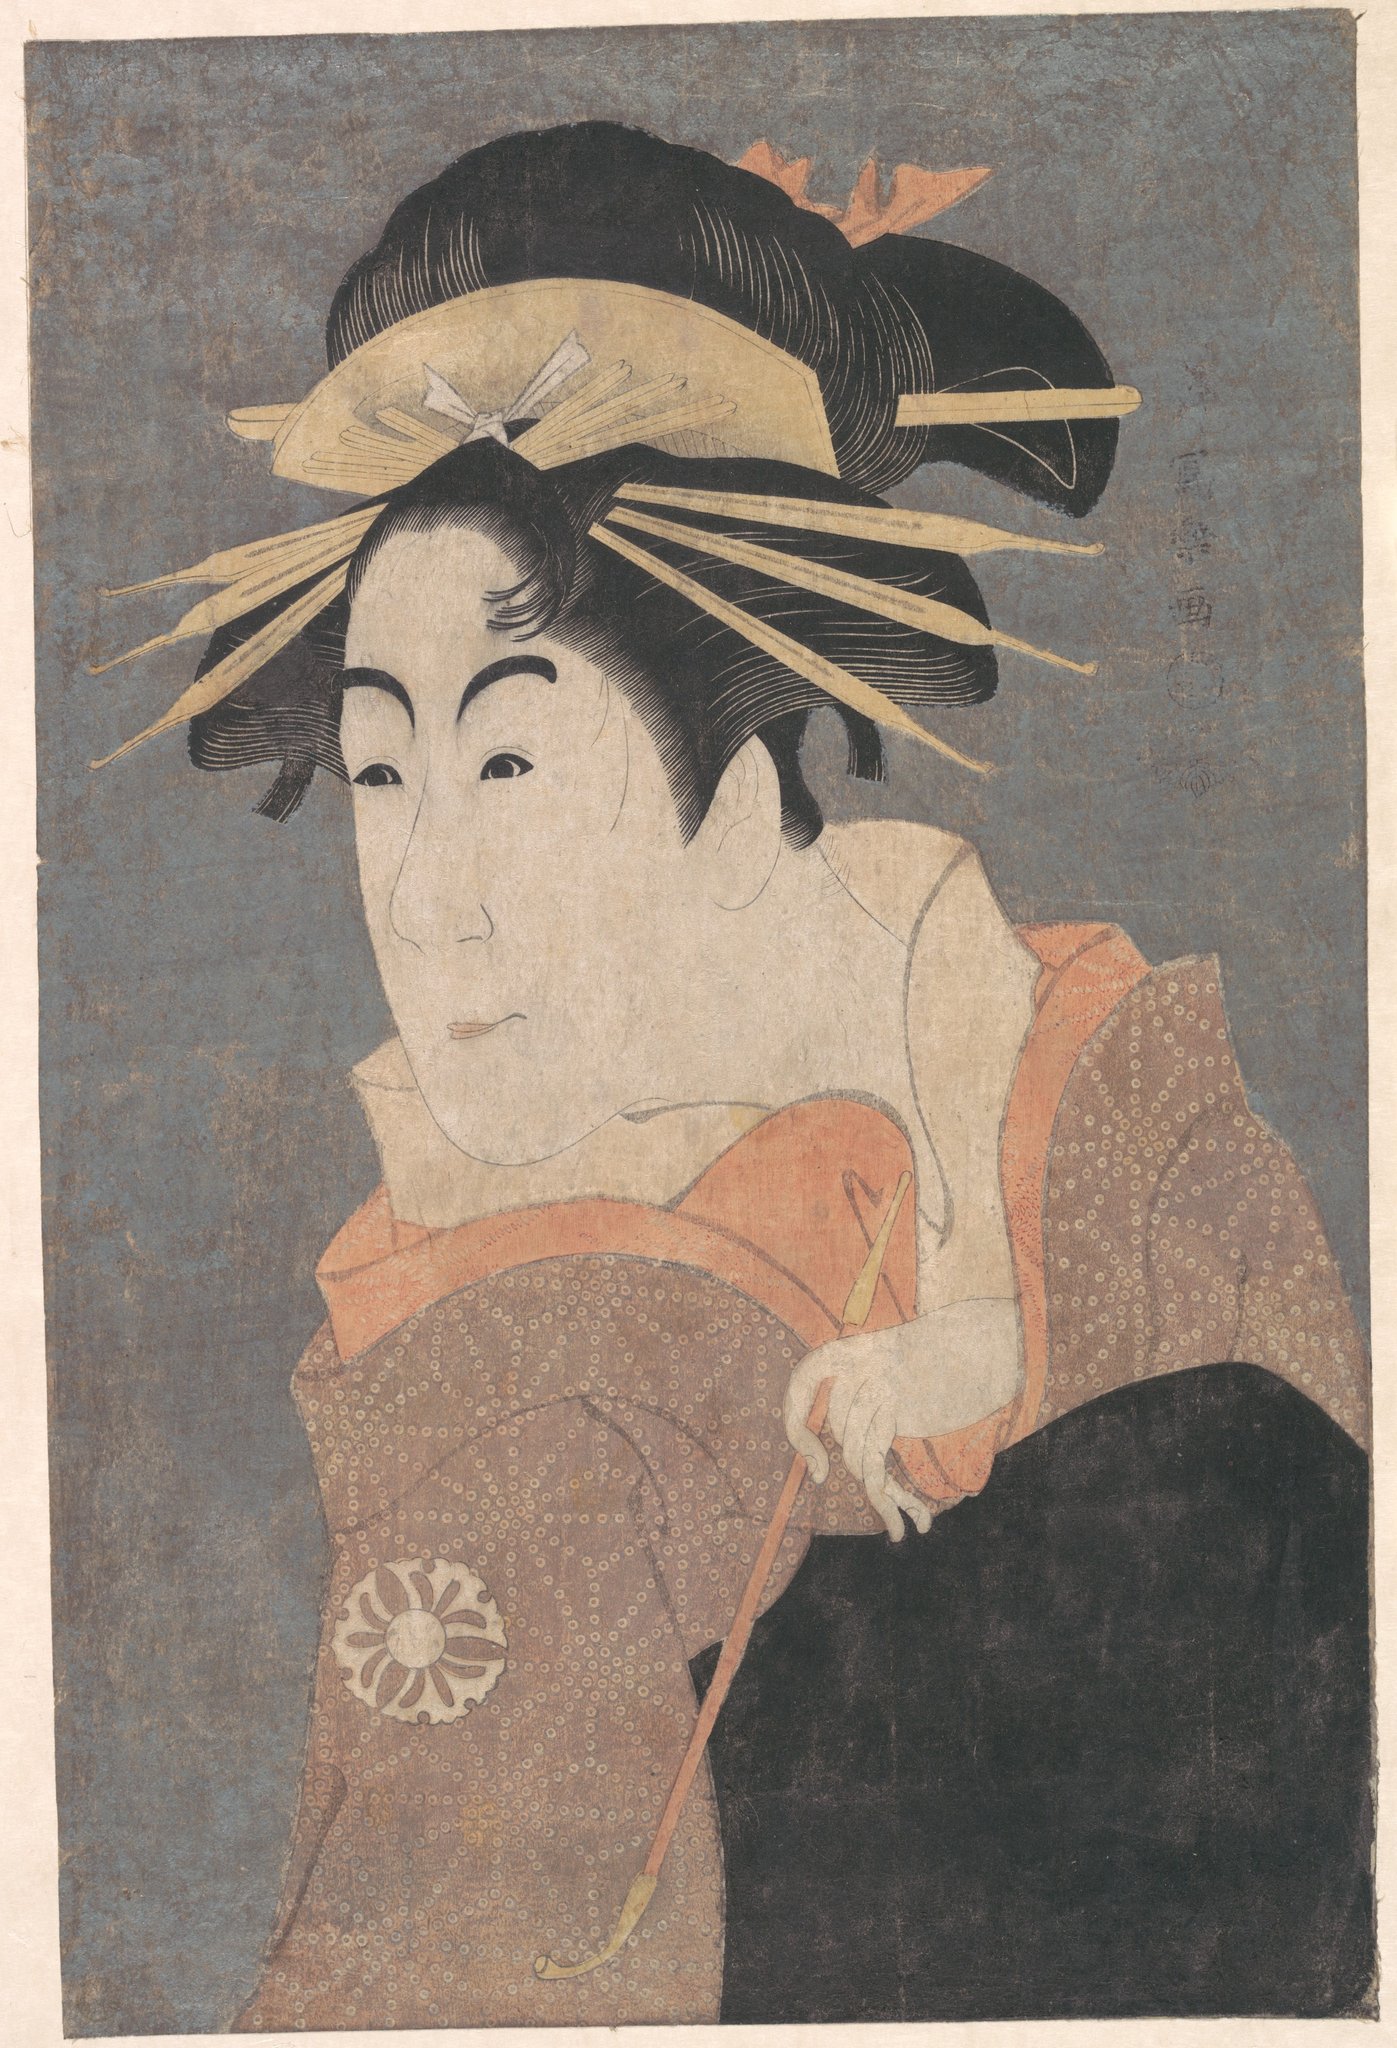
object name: print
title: Matsumoto Yonesaburo as Kewaizaka no Shosho in the Play "Katakiuchi Noriyaibanashi"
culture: japanese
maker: tōshūsai sharaku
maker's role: artist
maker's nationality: japanese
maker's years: 1794-1795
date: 1794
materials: ink, paper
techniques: woodblock print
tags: men,women,actors